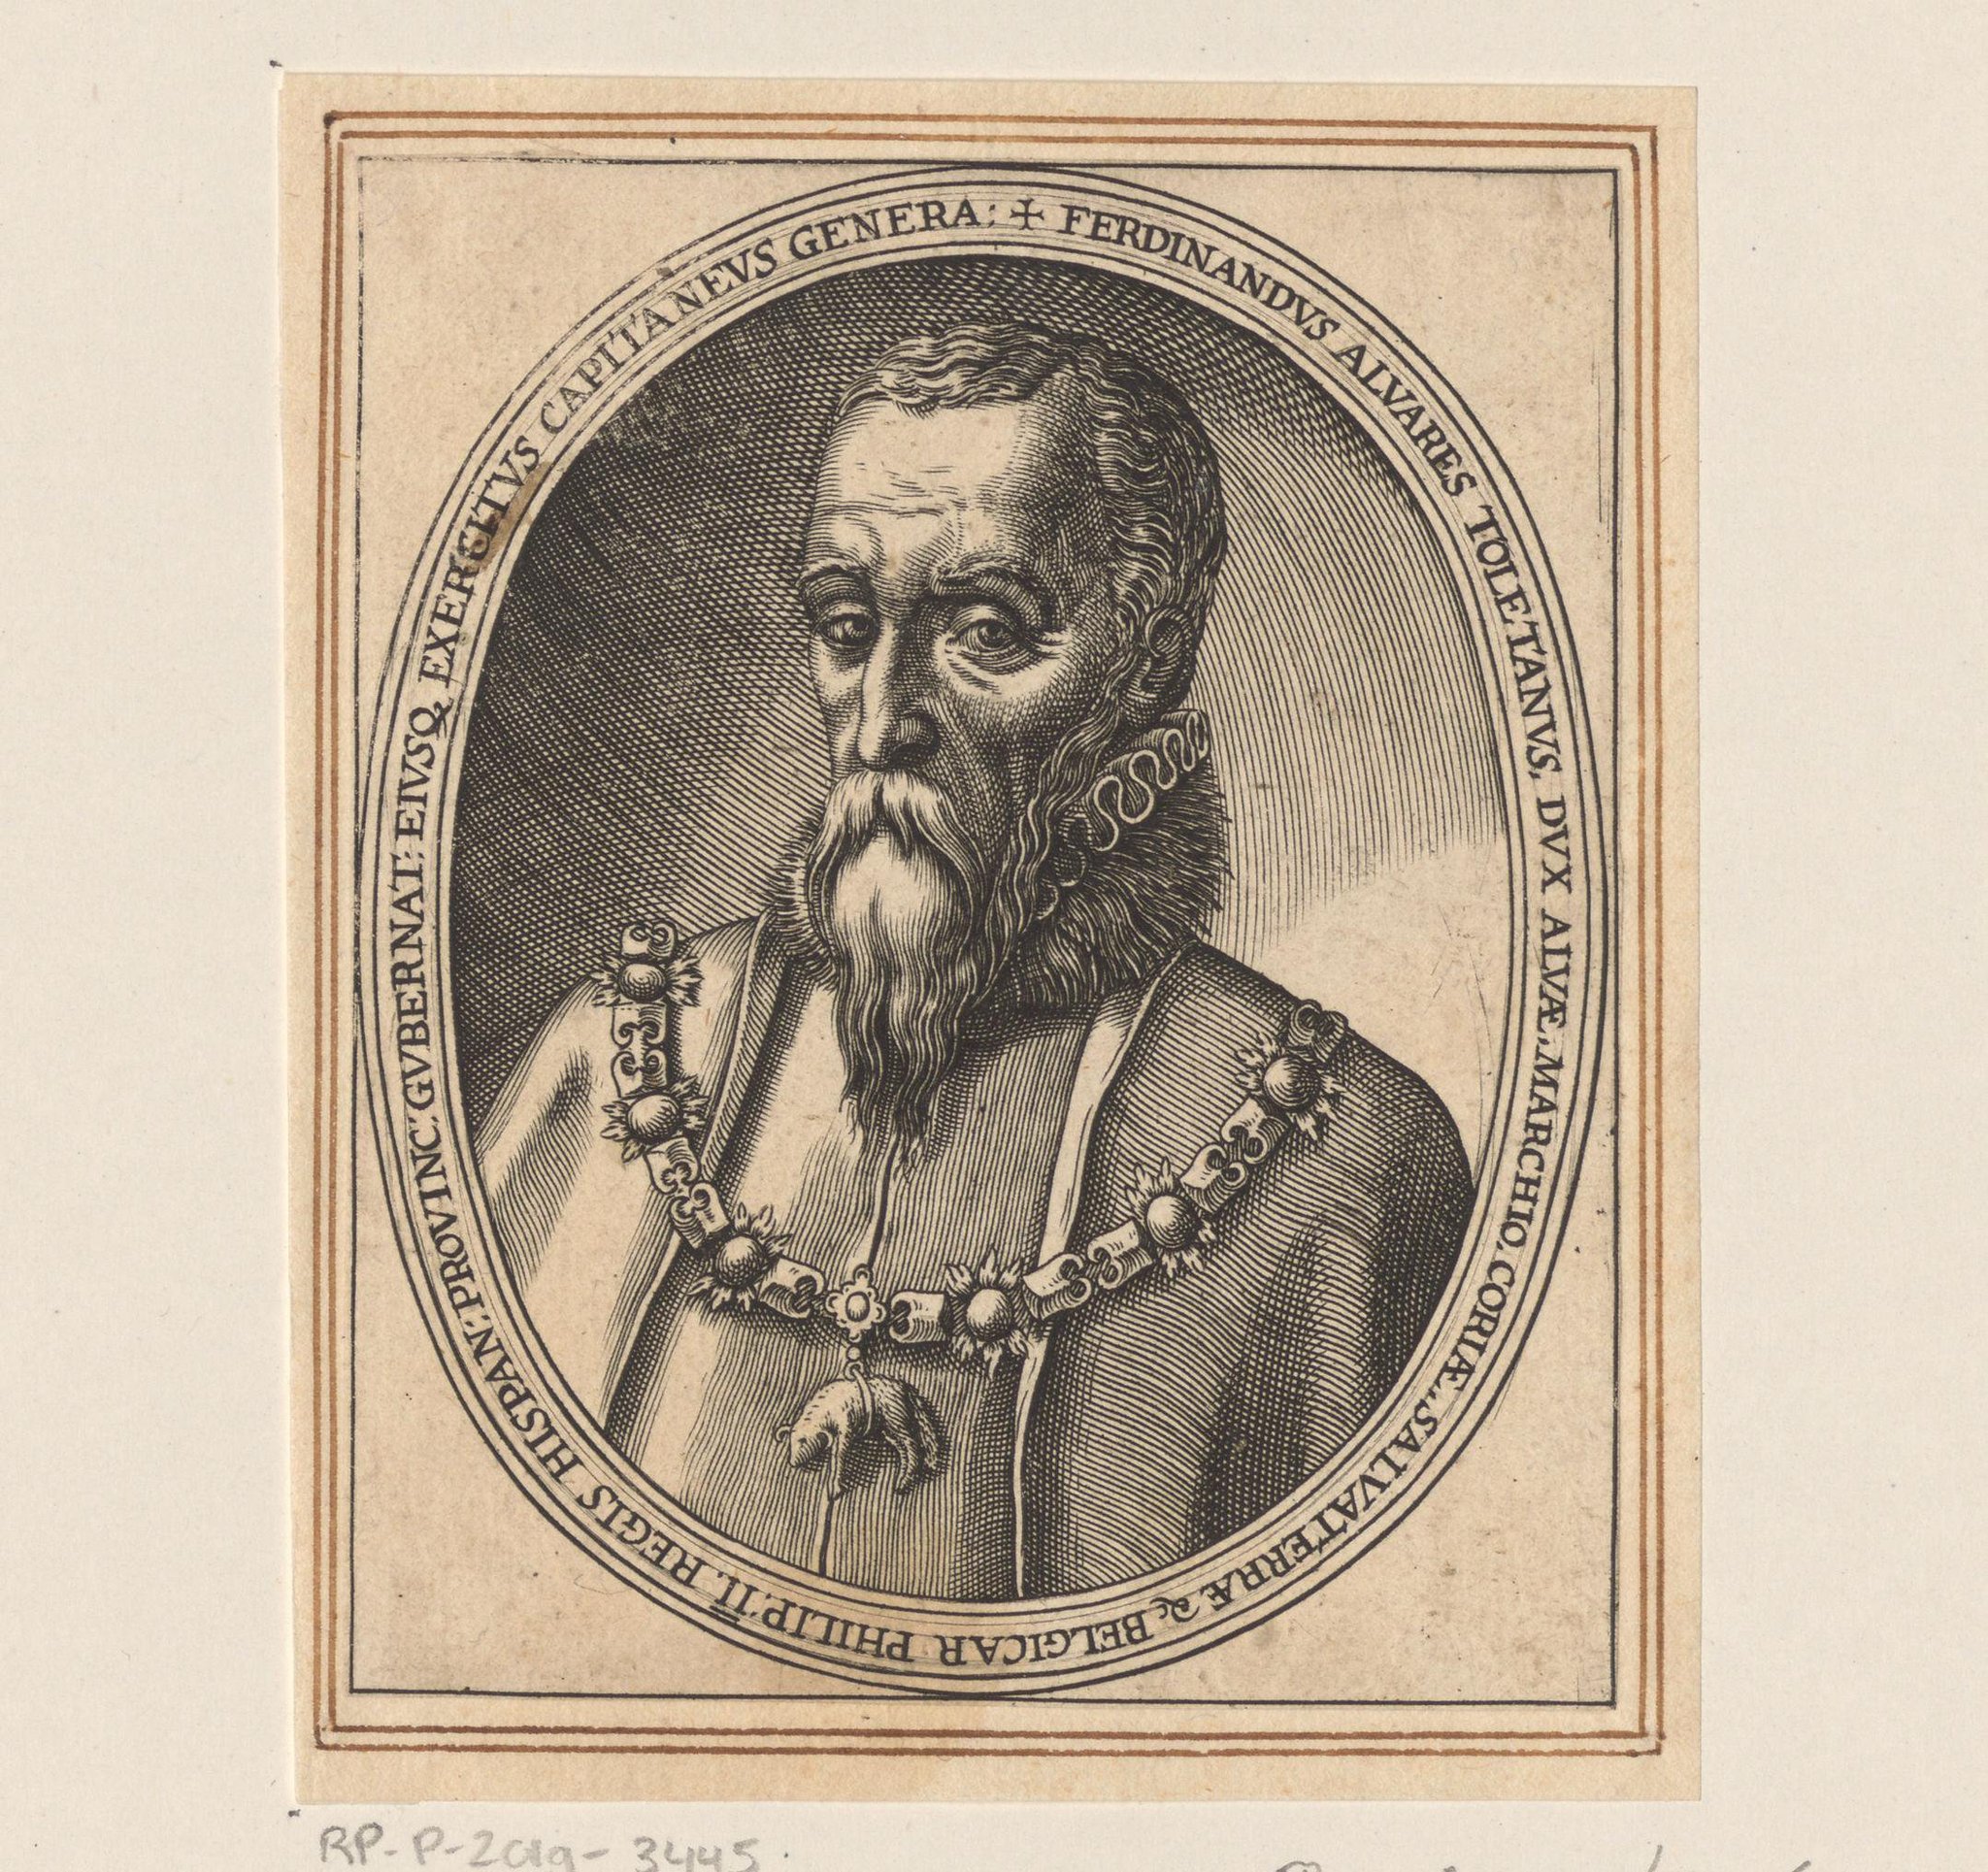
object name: print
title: Portret van Fernando Álvarez de Toledo, hertog van Alva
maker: Anonymous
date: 1600-1699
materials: paper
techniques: engraving, etching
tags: fernando álvarez de toledo (3rd duke of alba), historical persons, knighthood order of the golden fleece - insignia of a knighthood order, e.g.: badge, chain (with name of order)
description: Met om zijn nek de keten van de Orde van het Gulden Vlies.